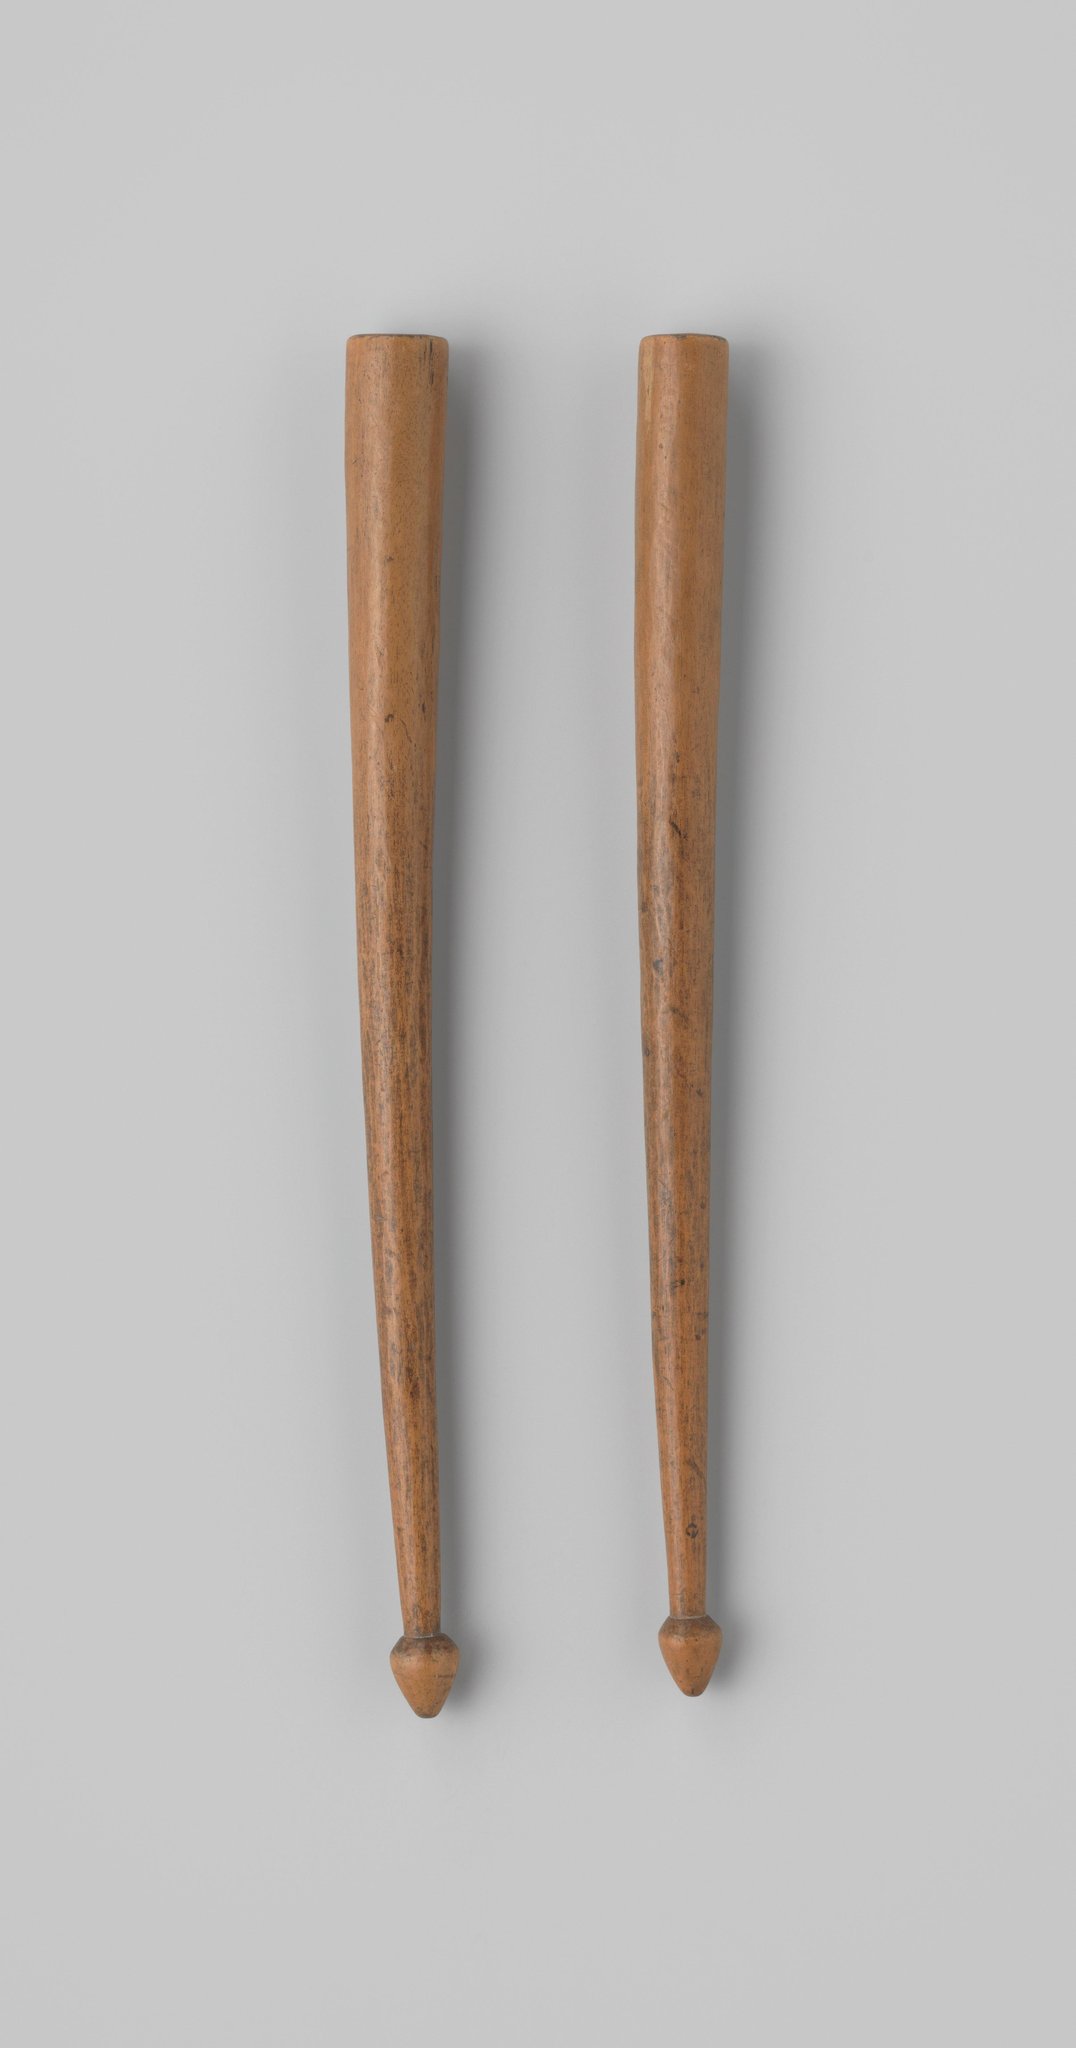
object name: percussion instrument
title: Drumsticks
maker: Anonymous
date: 1800-1900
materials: wood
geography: europe